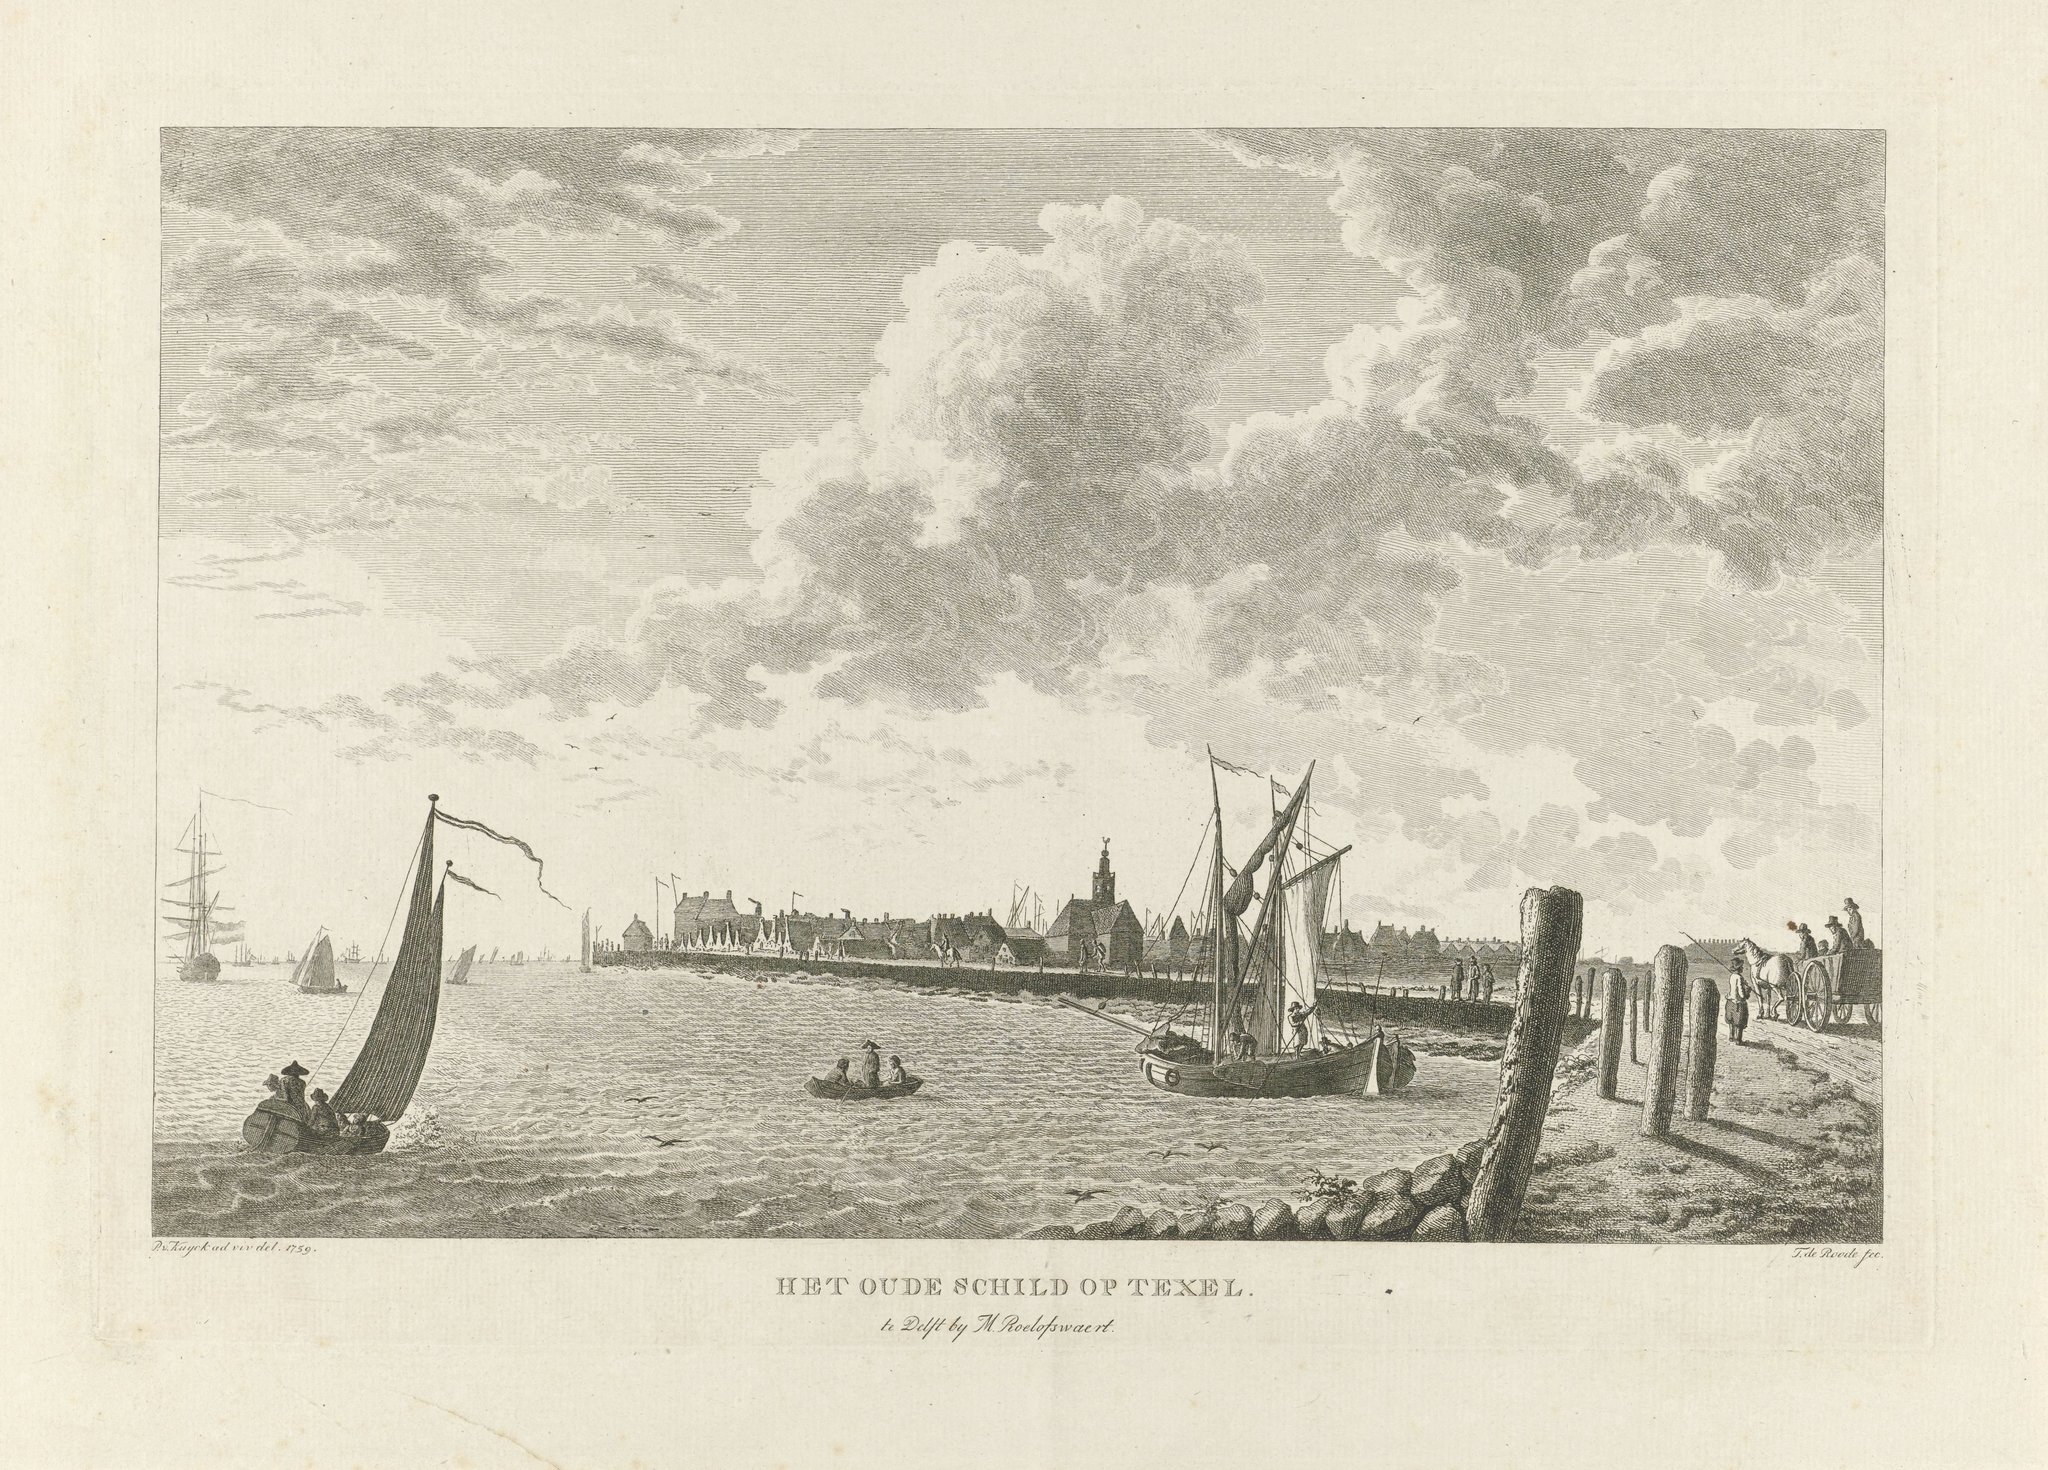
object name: print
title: Gezicht op Oudeschild op Texel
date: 1789-1800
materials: paper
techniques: etching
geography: delft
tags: prospect of village, silhouette of village, sailing-ship, sailing-boat, road, path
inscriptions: collector's mark: Lugt 2228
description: Gezicht vanaf de Waddenzee op de contouren van het dorp Oudeschild op Texel. Op de voorgrond verschillende boten en rechts een weg langs de waterkant.